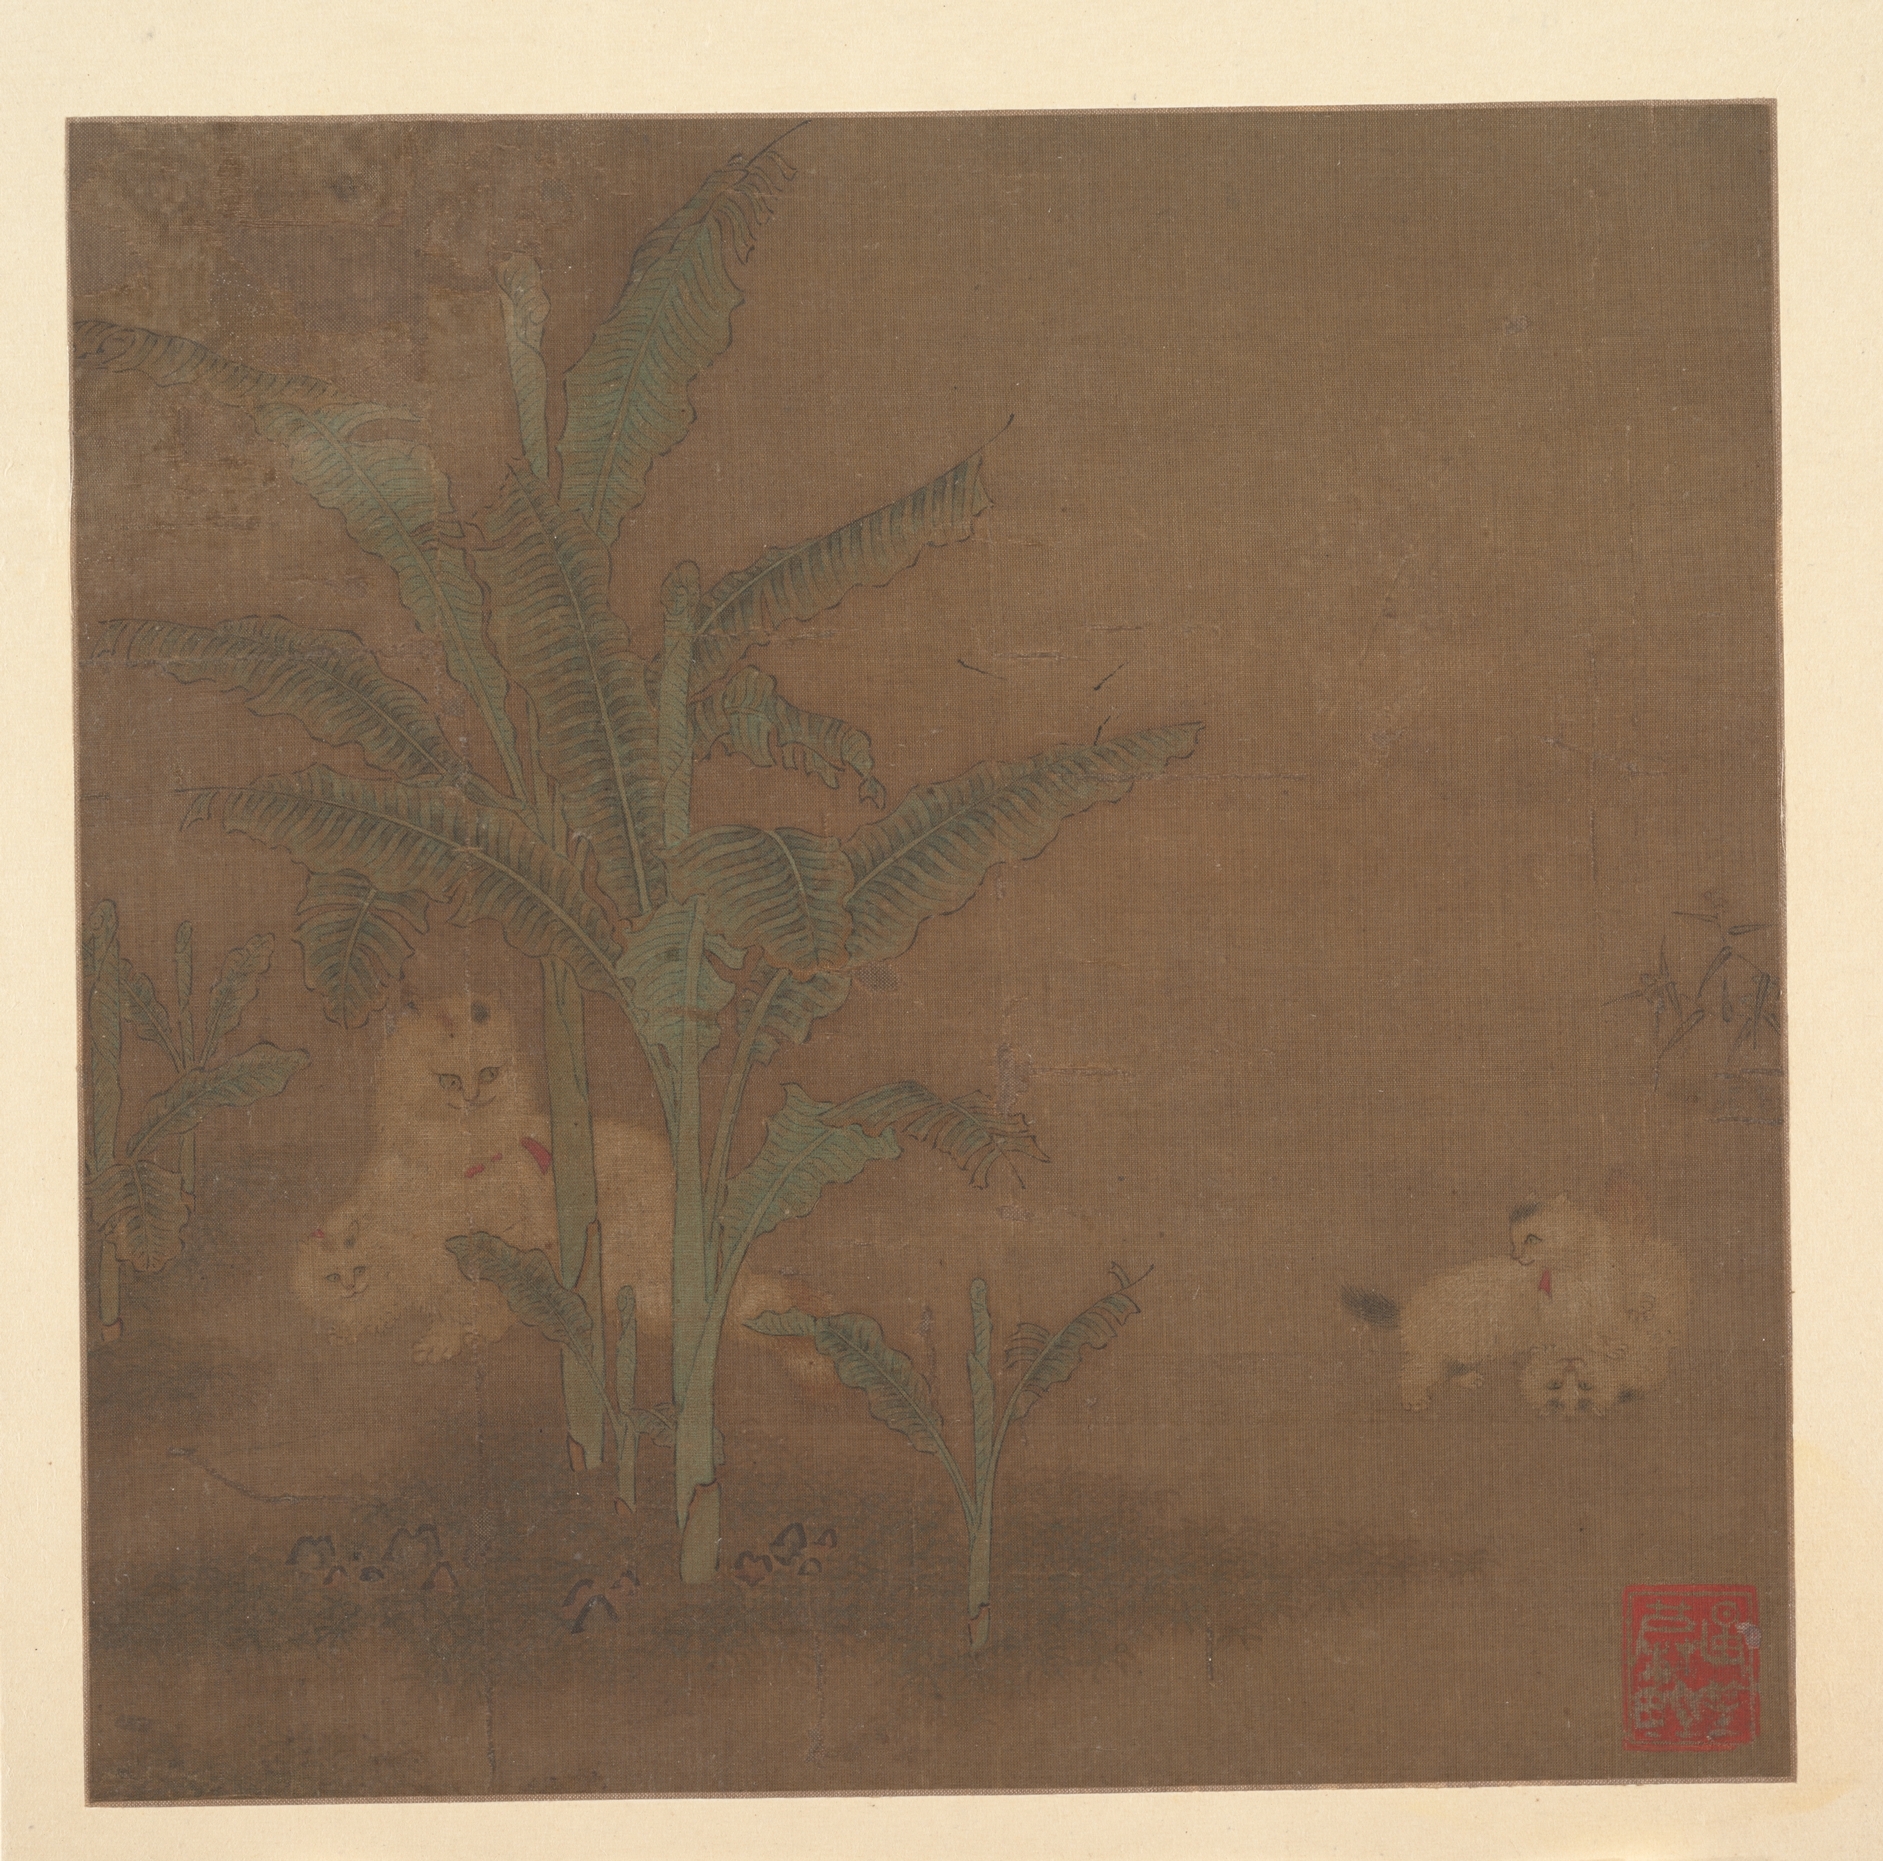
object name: album leaf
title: Frolicking Kittens under a Banana Tree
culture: chinese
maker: unidentified artist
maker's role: artist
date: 1401-1500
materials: ink, silk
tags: cats